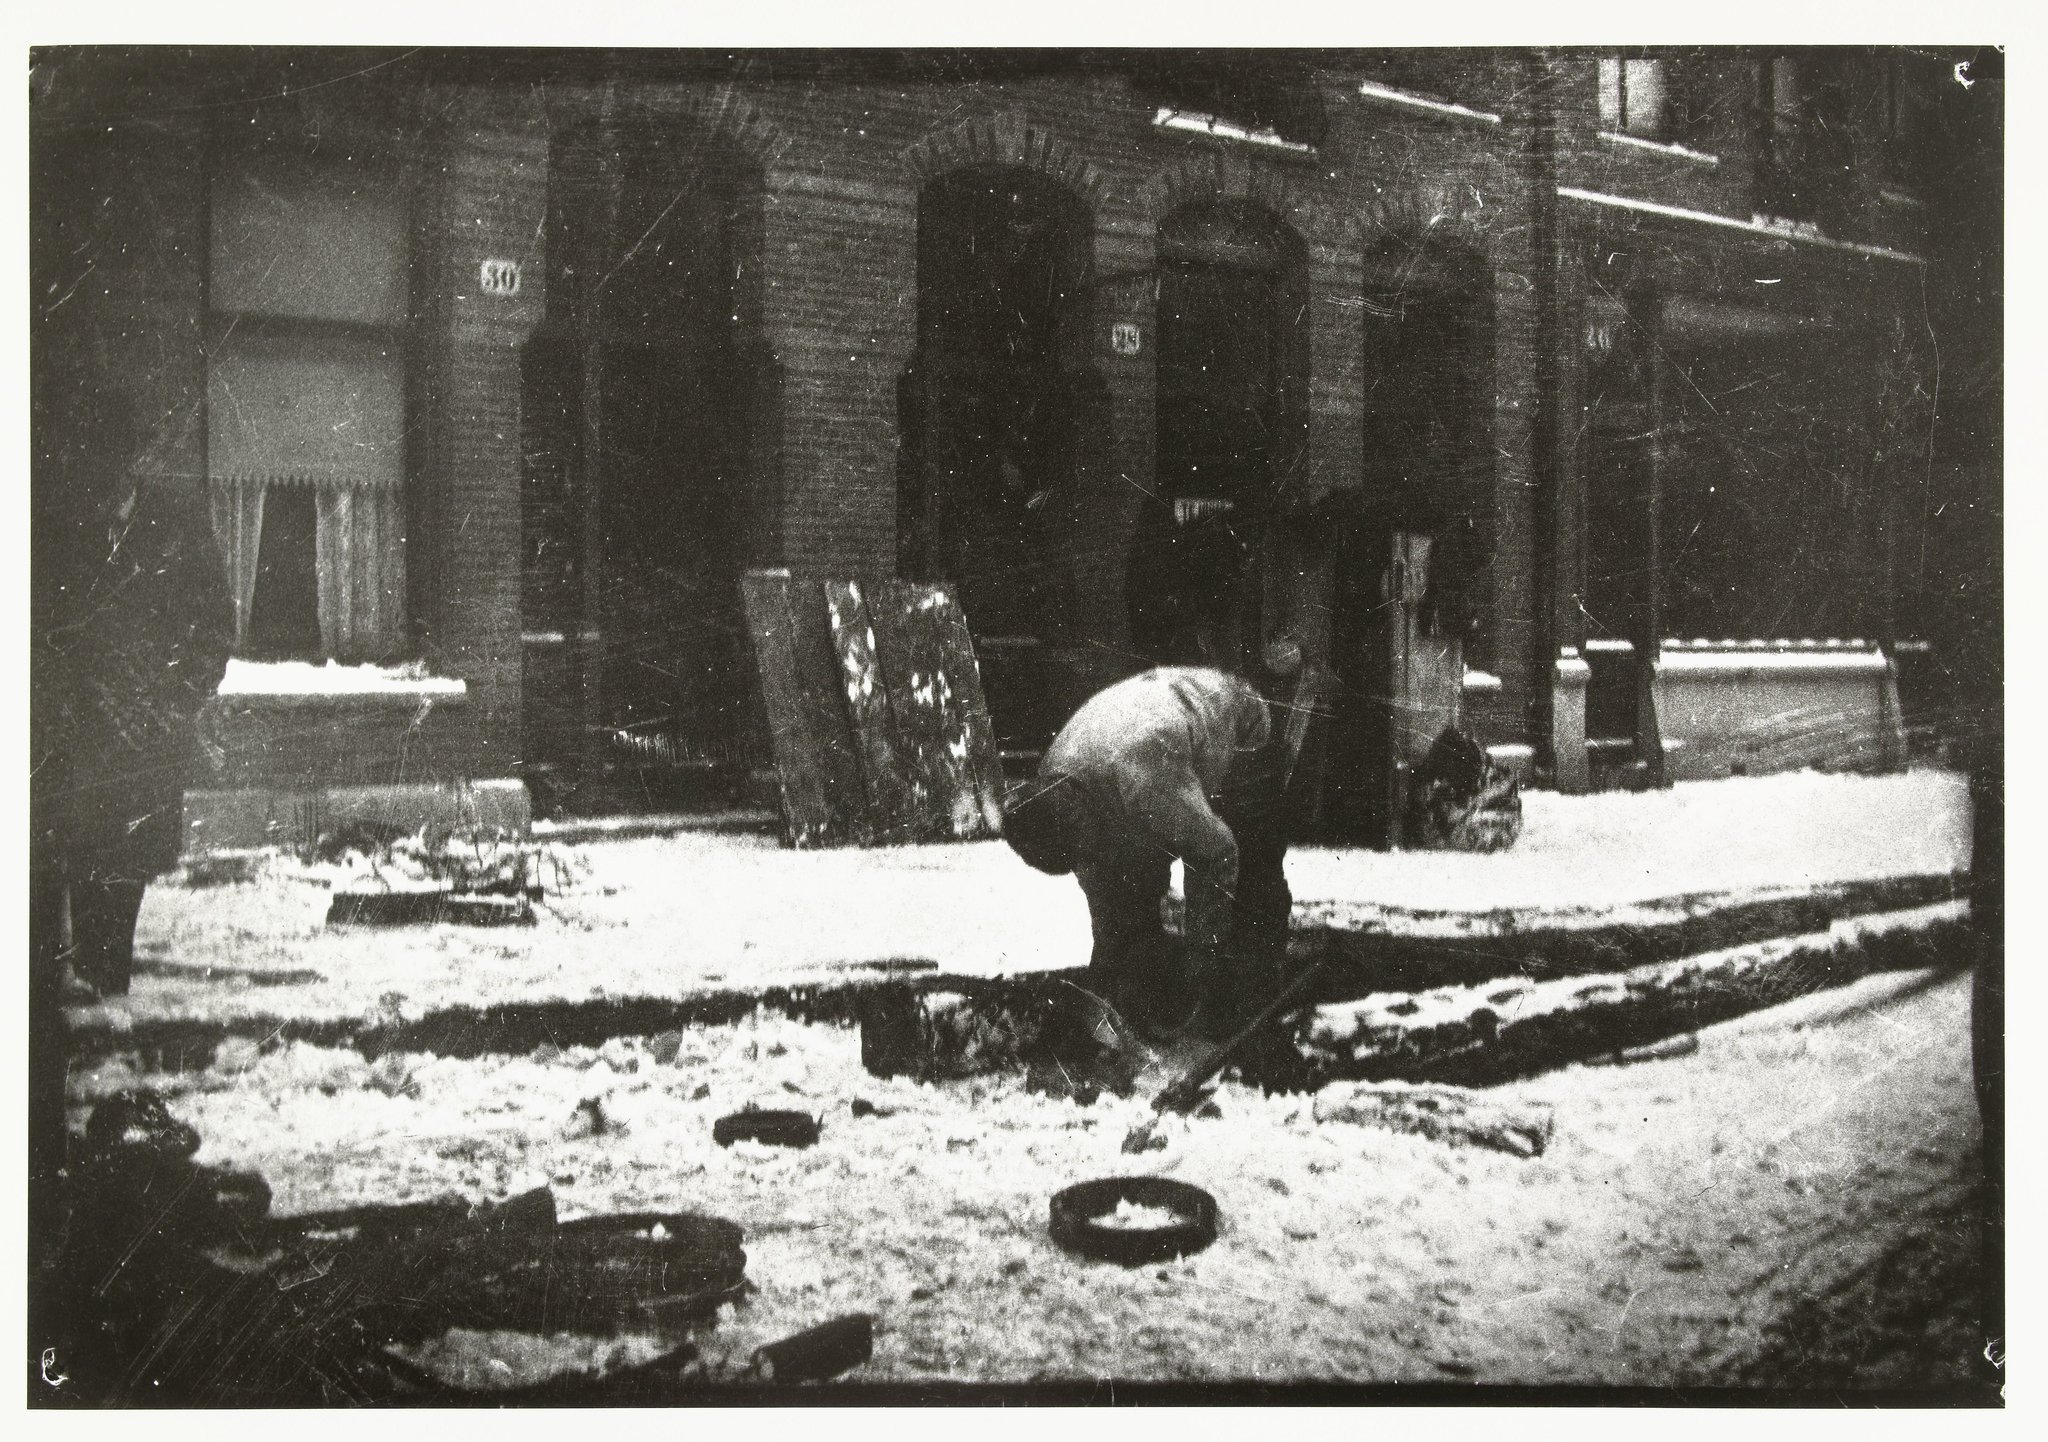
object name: photograph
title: Bouwvakker aan het werk in de sneeuw in Amsterdam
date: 1890-1910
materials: paper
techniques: gelatin silver print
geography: amsterdam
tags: amsterdam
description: Moderne afdruk van negatief BR 1040 (collectie RKD).